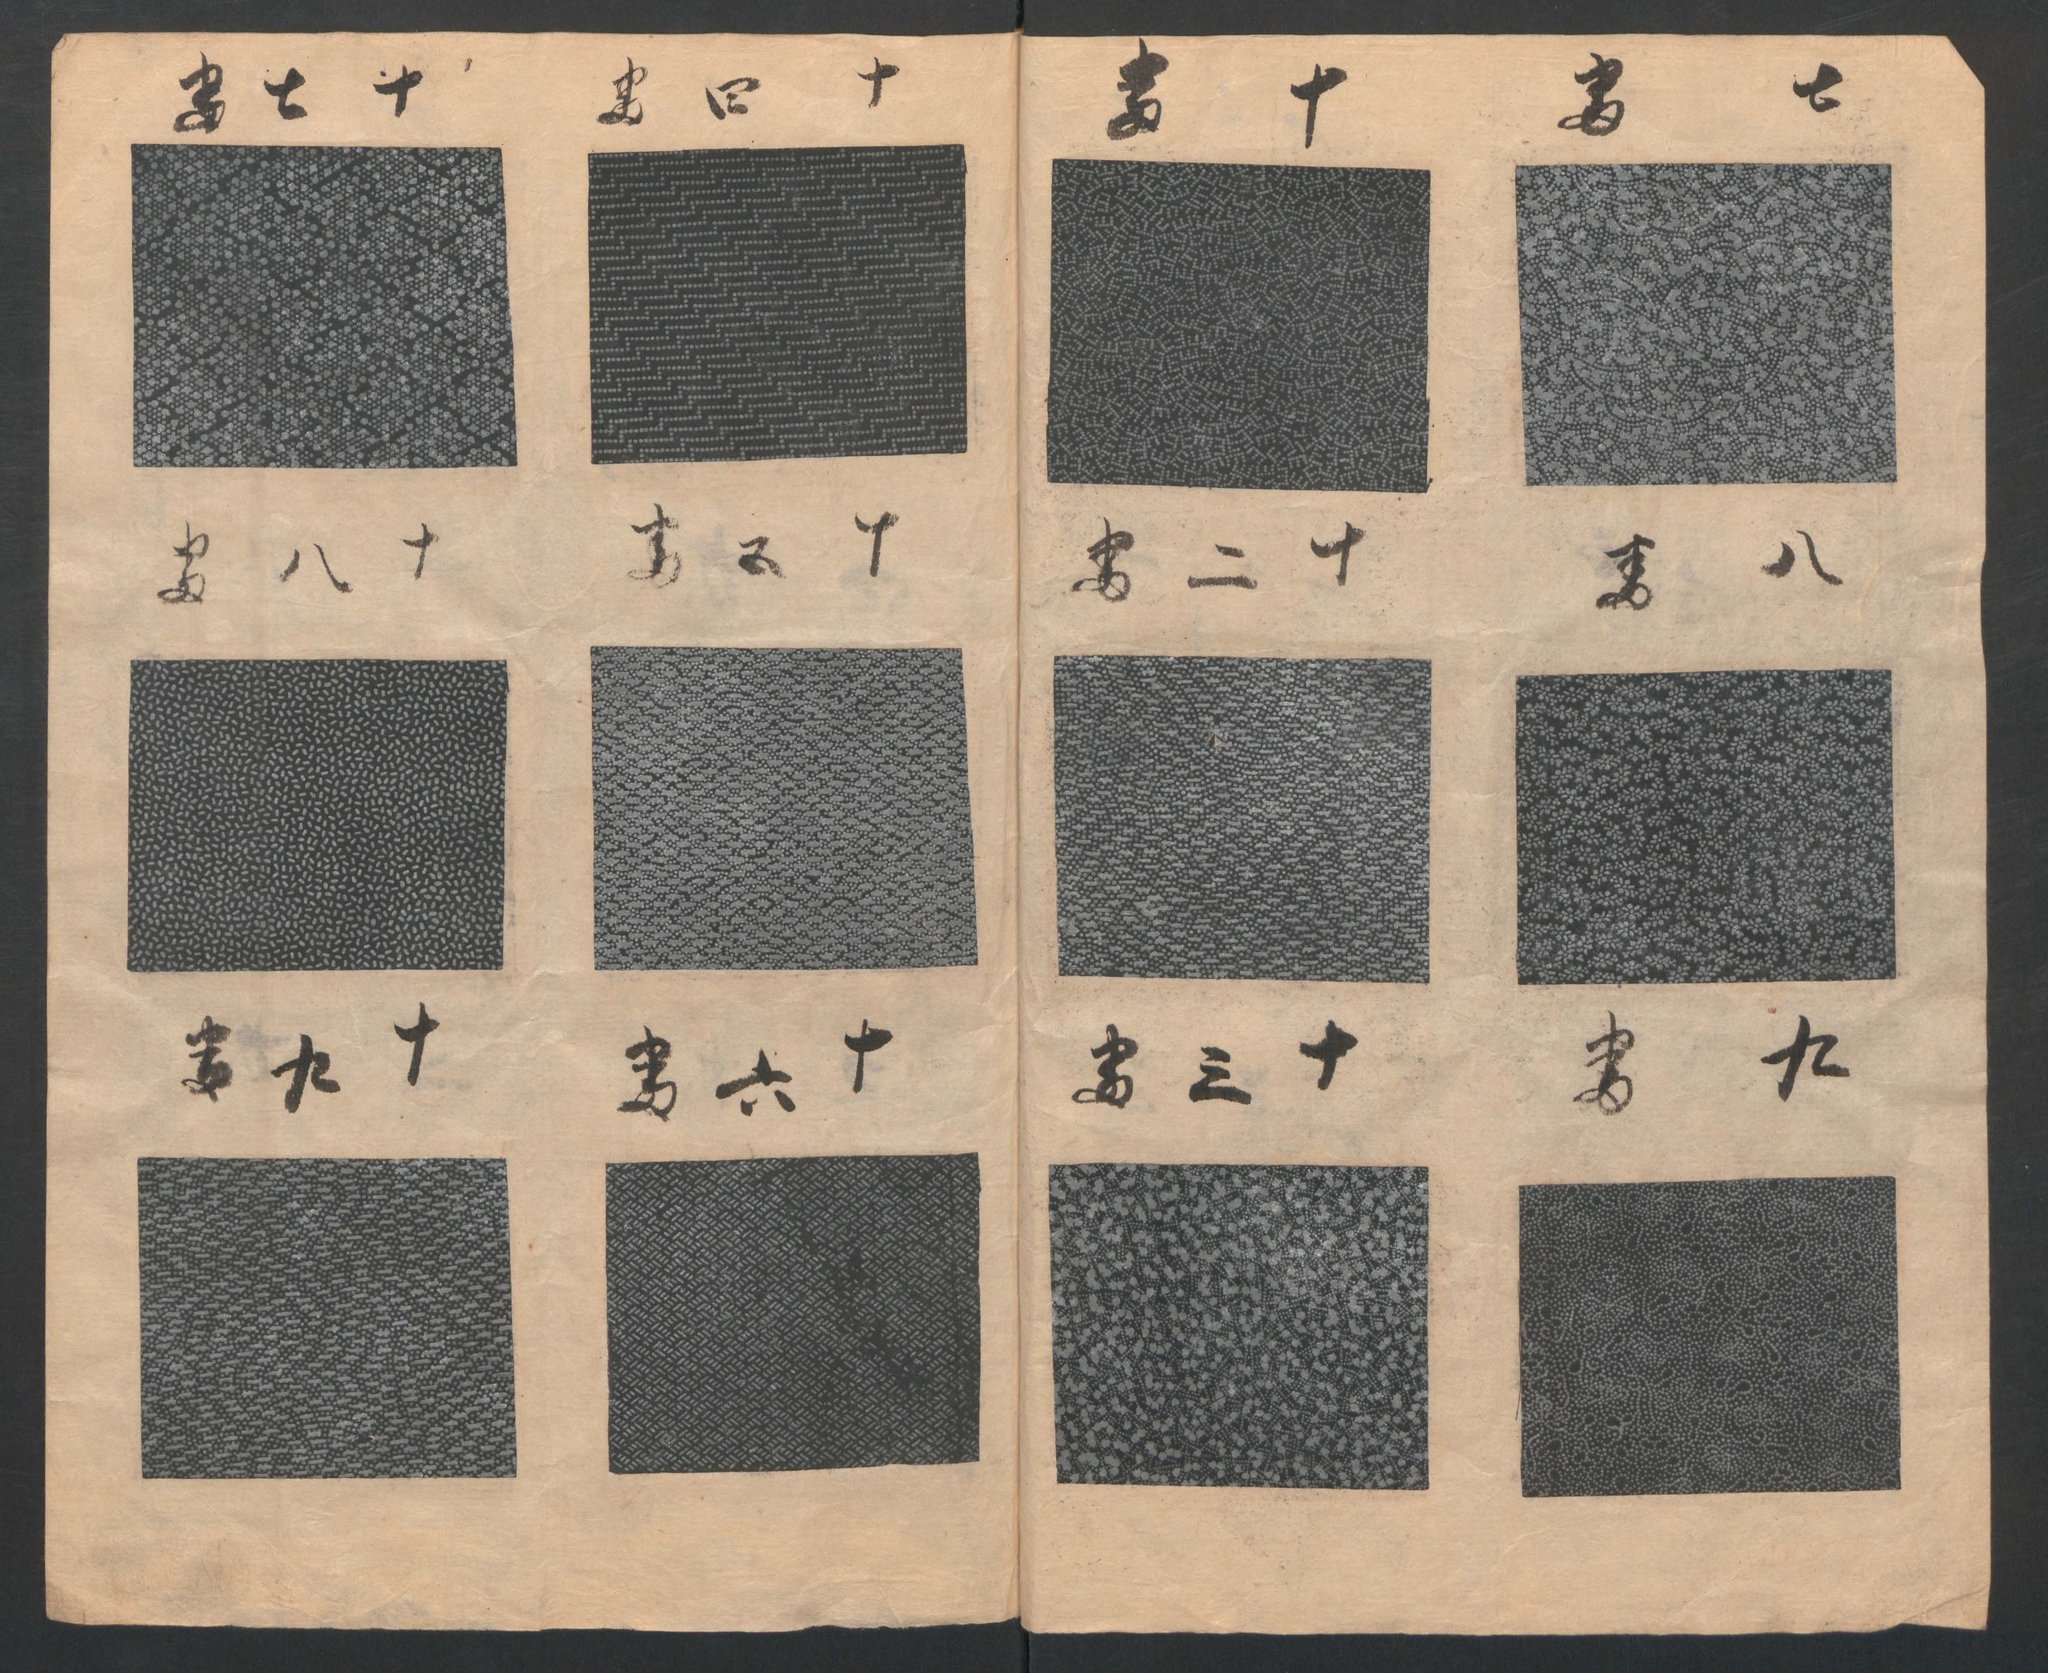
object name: illustrated book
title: Book of Designs (Osaka chō Sakoeya) 大阪町迫江屋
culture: japanese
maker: unidentified artist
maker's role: artist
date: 1700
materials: ink, paper